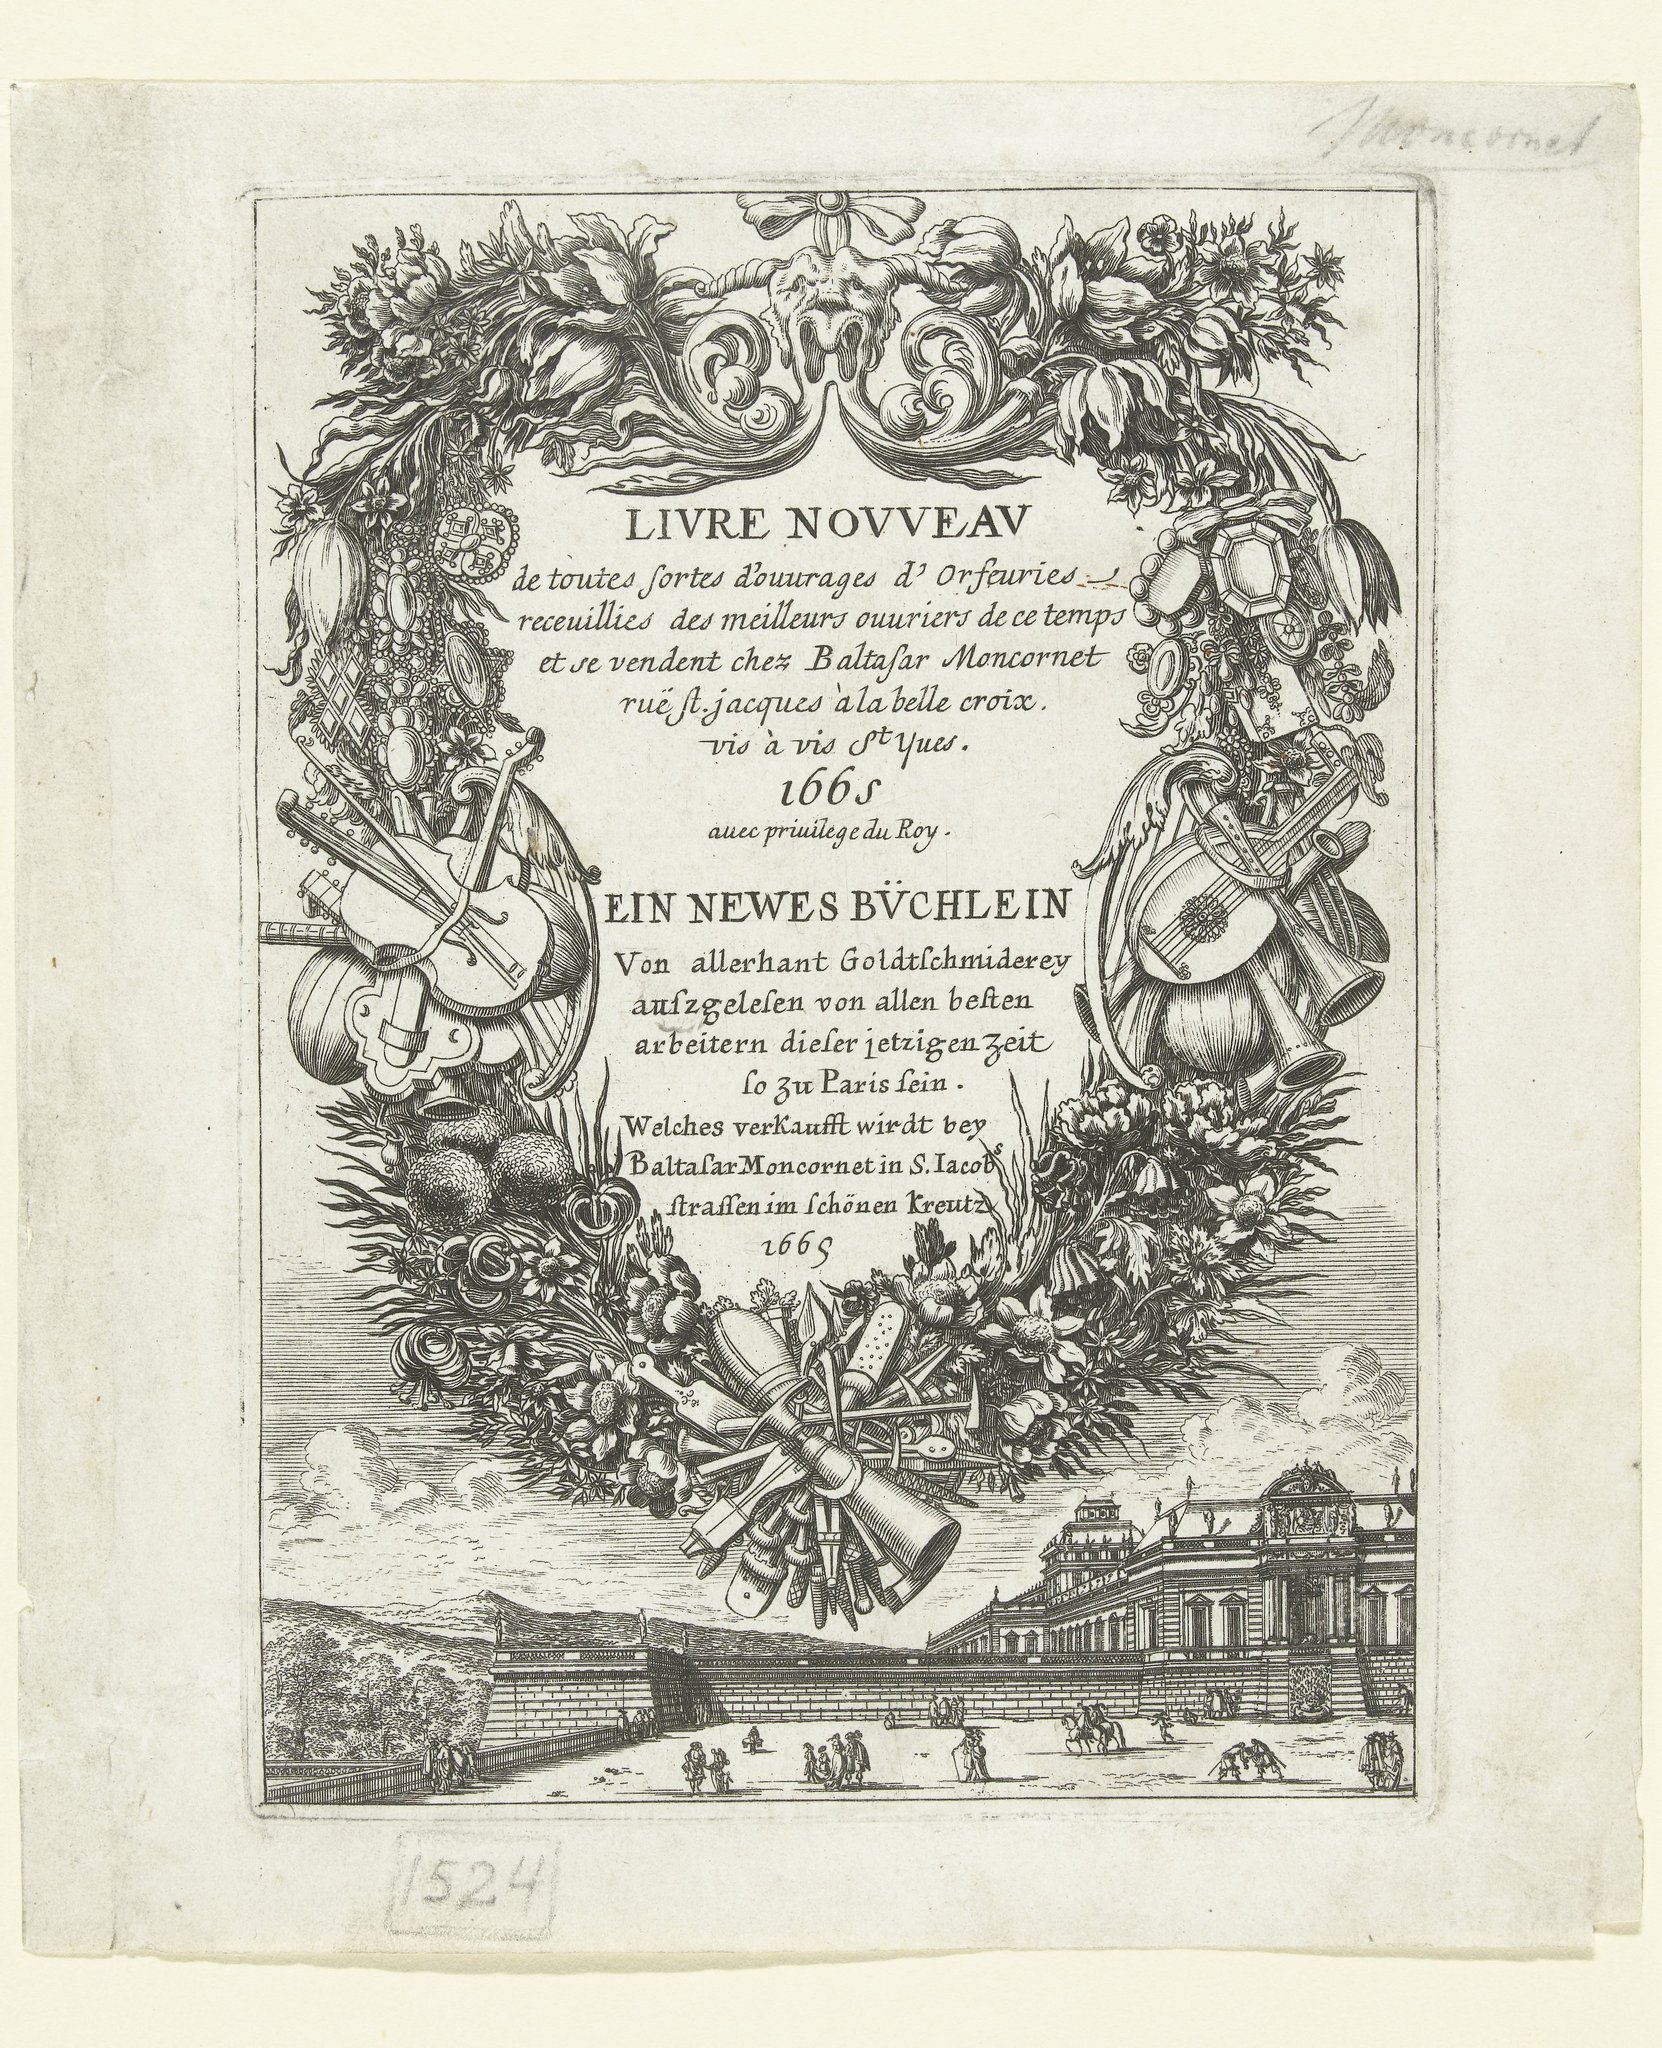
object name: titelblad, titelpagina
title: Livre Nouveau de toutes sortes d'ouurages d'Orfeuries receuillies des Maylleurs ouuriers de ce temps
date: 1665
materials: paper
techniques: engraving, etching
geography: france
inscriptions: date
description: Cartouche met titel in Frans en Duits, hangend aan een masker en bestaande uit bloemen, juwelen, trofeeën van muziekinstrumenten en gereedschap van edelsmeden. Uit serie van 12 bladen met ontwerpen van juwelen voor goudsmeden en emailleurs. Derde editie.